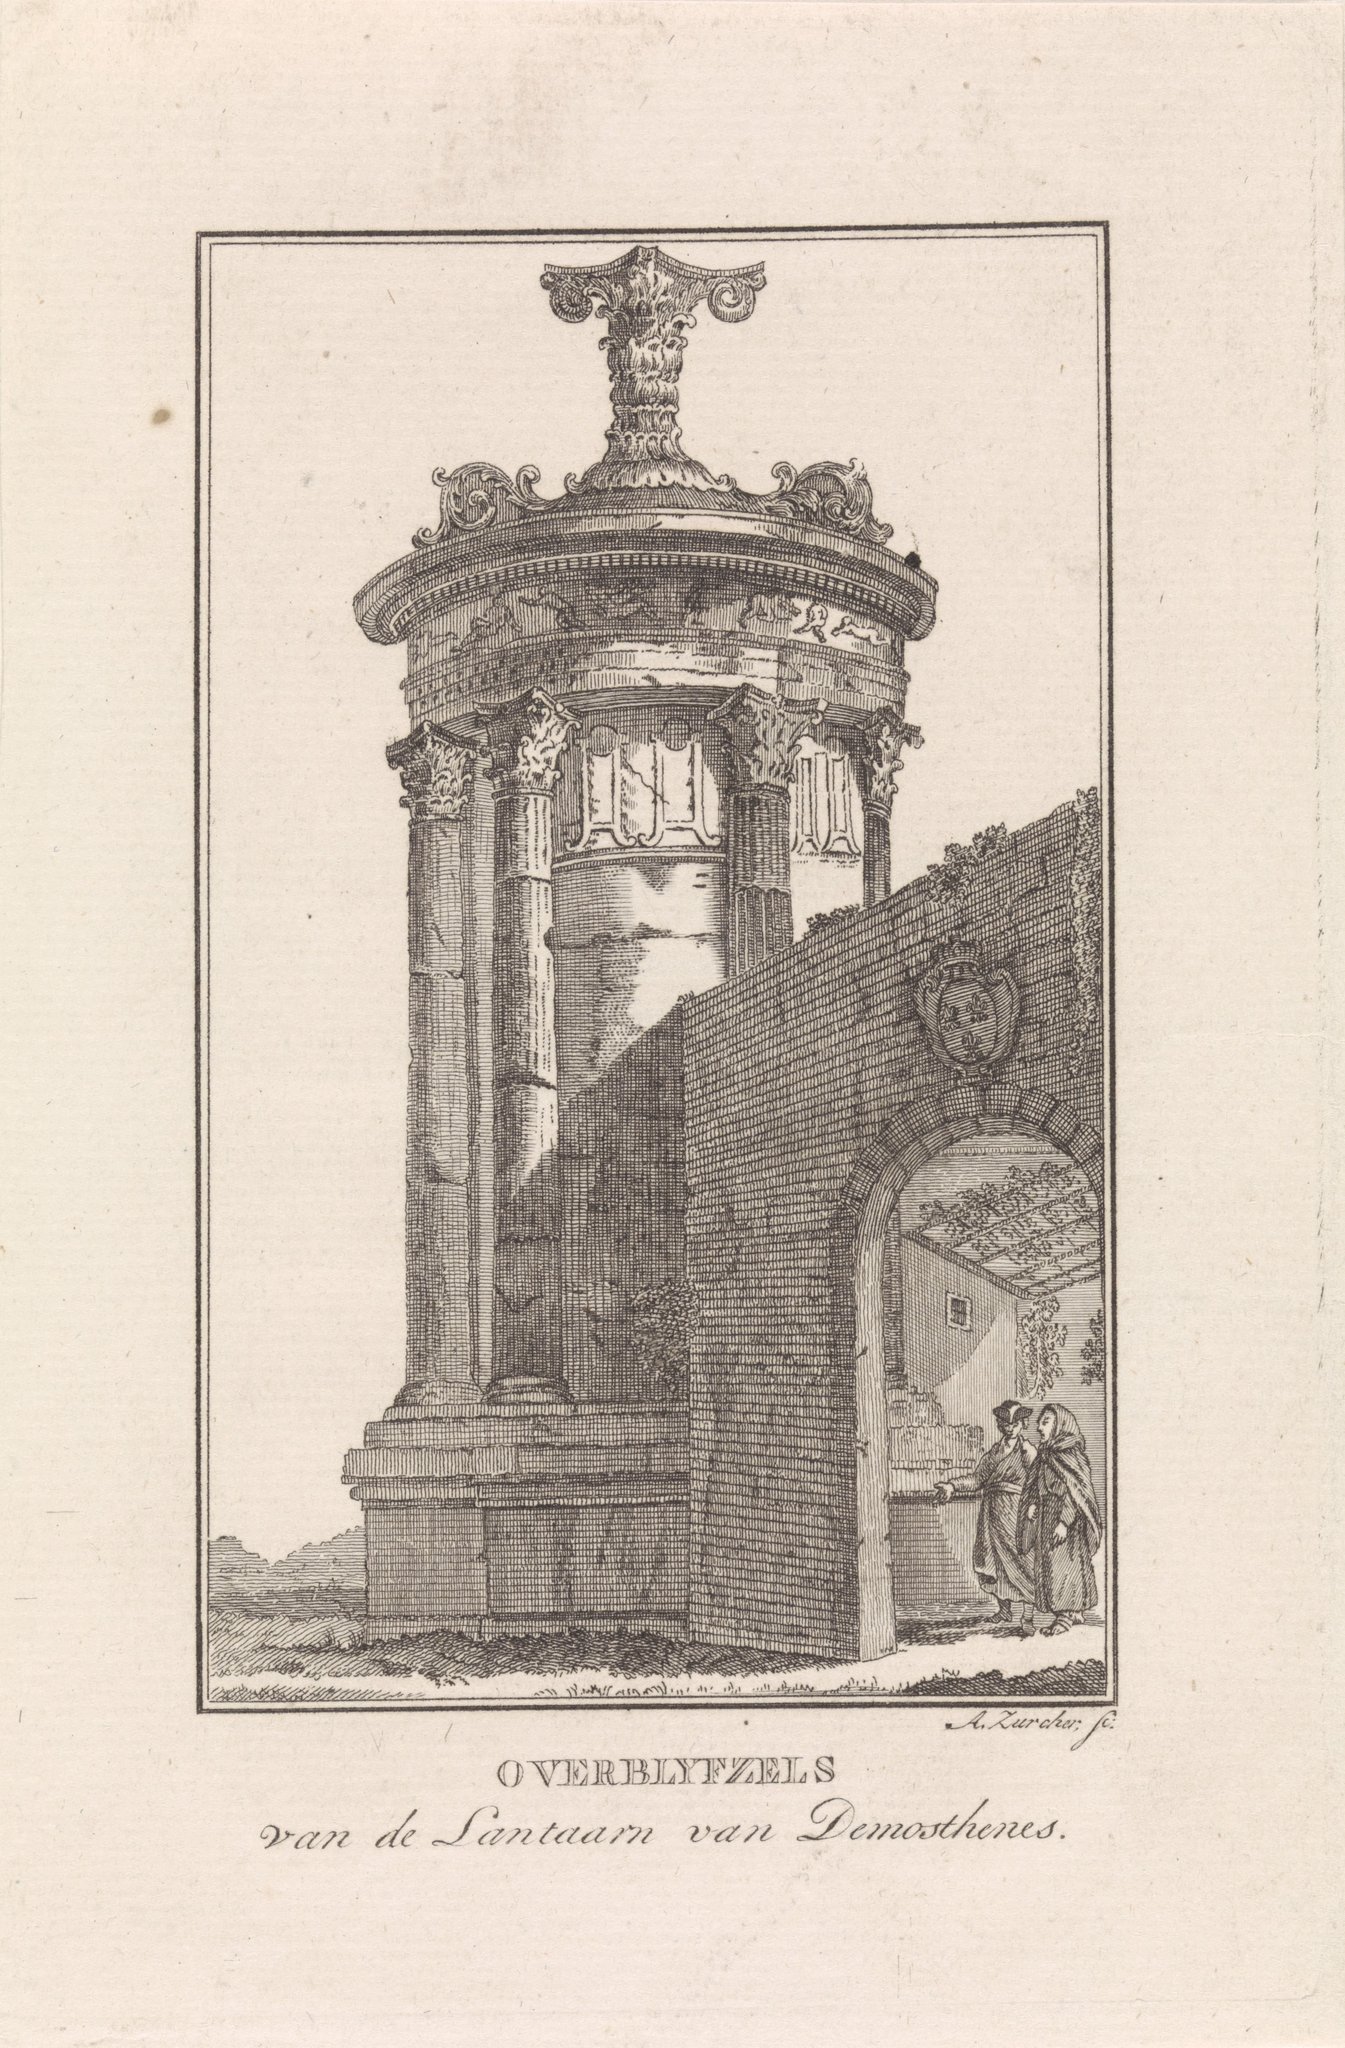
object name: print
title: Monument van Lysicrates in Athene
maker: antoni zürcher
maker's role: print maker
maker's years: 1754-1837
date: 1765-1837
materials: paper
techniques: etching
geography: netherlands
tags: architecture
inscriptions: collector's mark: Lugt 2228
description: Het monument van Lysicrates in Athene, ook wel de Lantaarn van Demosthenes genoemd.